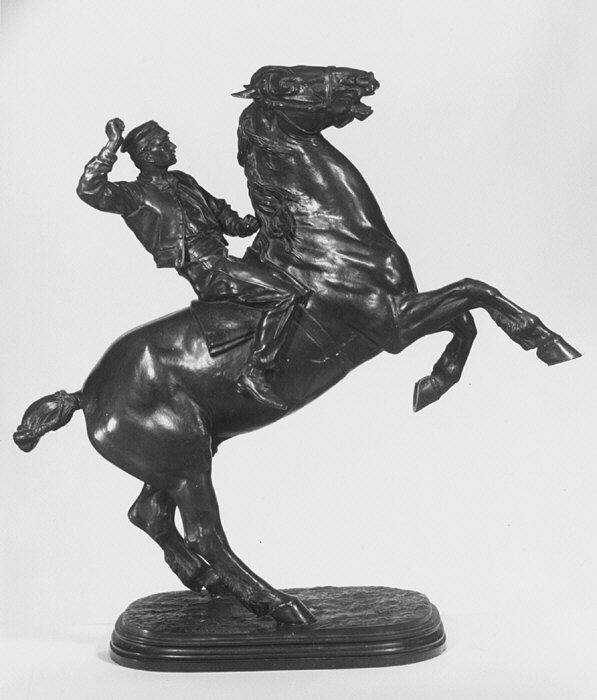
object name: statuette group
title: Boy and Rearing Stallion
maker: isidore bonheur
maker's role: artist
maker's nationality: french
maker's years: 1827-1901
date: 1860-1878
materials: bronze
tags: boys,horses